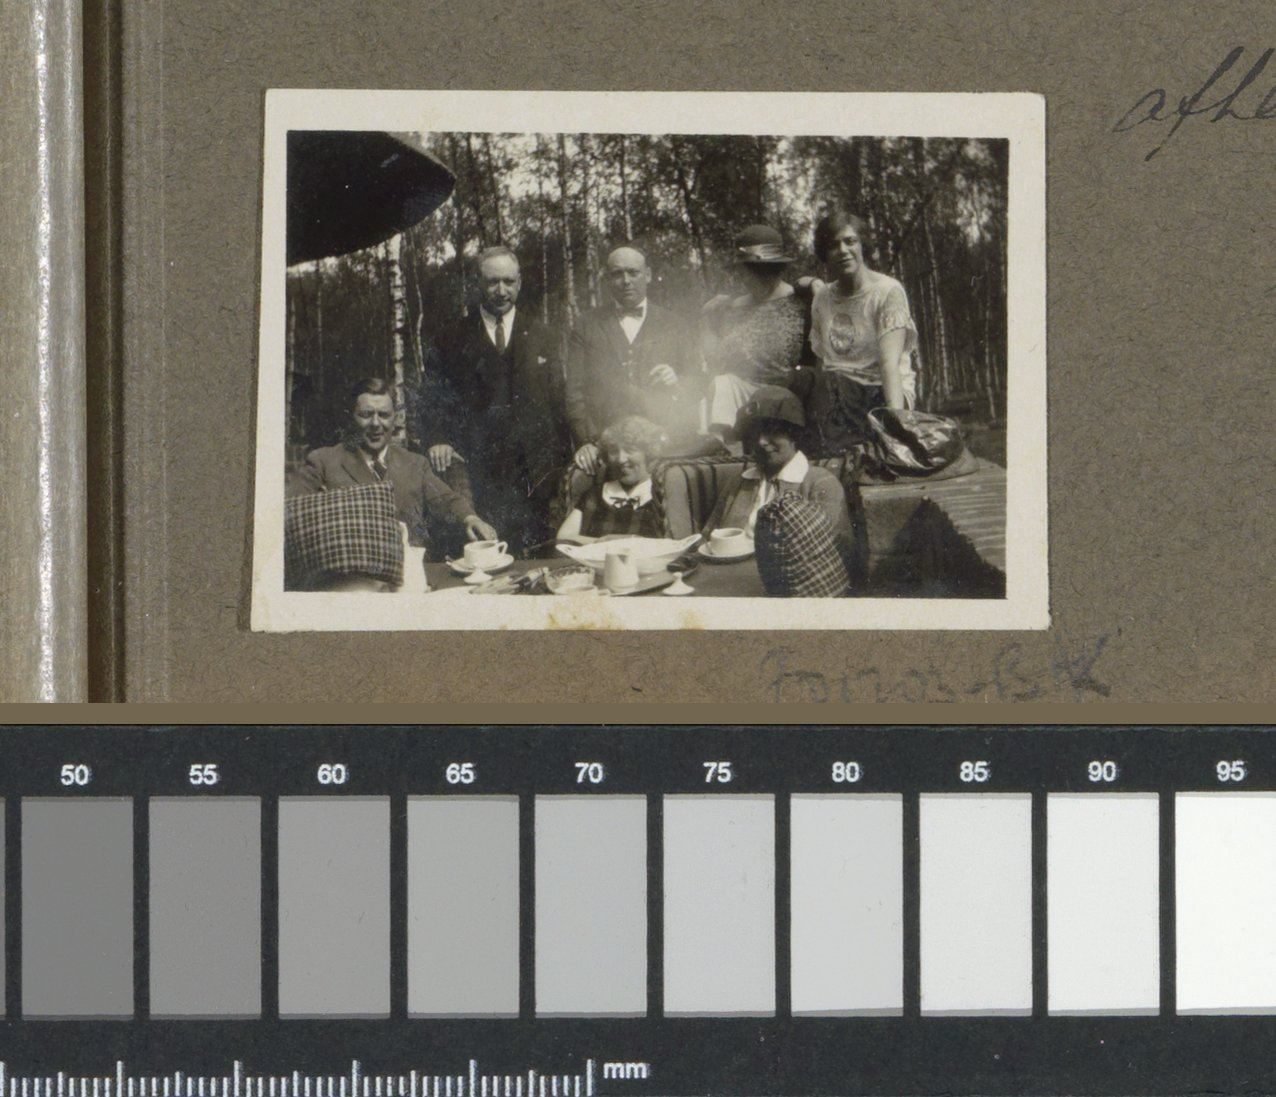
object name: photograph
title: Pic-nic op de hei bij Amersfoort, mei '24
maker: Anonymous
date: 1905-1924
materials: photographic support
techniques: gelatin silver print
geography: netherlands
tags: eating and drinking, netherlands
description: Gezelschap aan de thee op het terras van restaurant Groot Kievitsdal aan de Hilversumsestraatweg 19 in Baarn. Onderdeel van fotoalbum van een onbekende Nederlandse familie met opnames van Suriname, Europa en Nederlands-Indië.